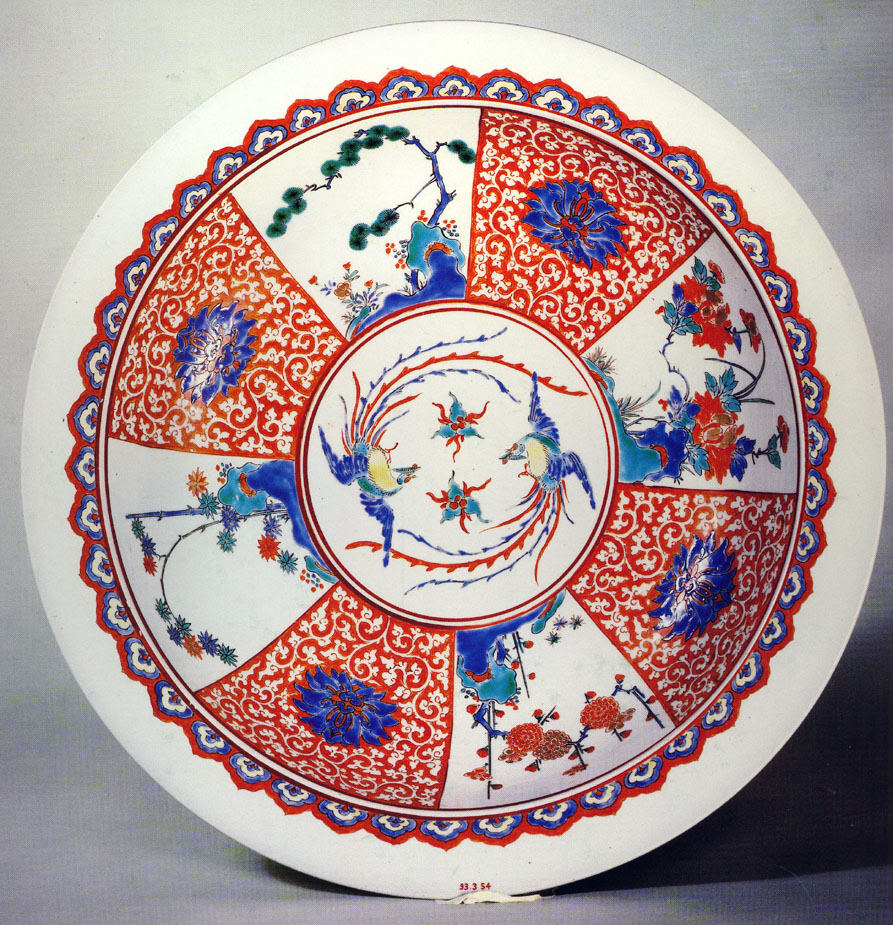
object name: plate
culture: japanese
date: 1701-1733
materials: enamel, gilt, porcelain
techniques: overglaze, painting, polychrome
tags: birds,flowers